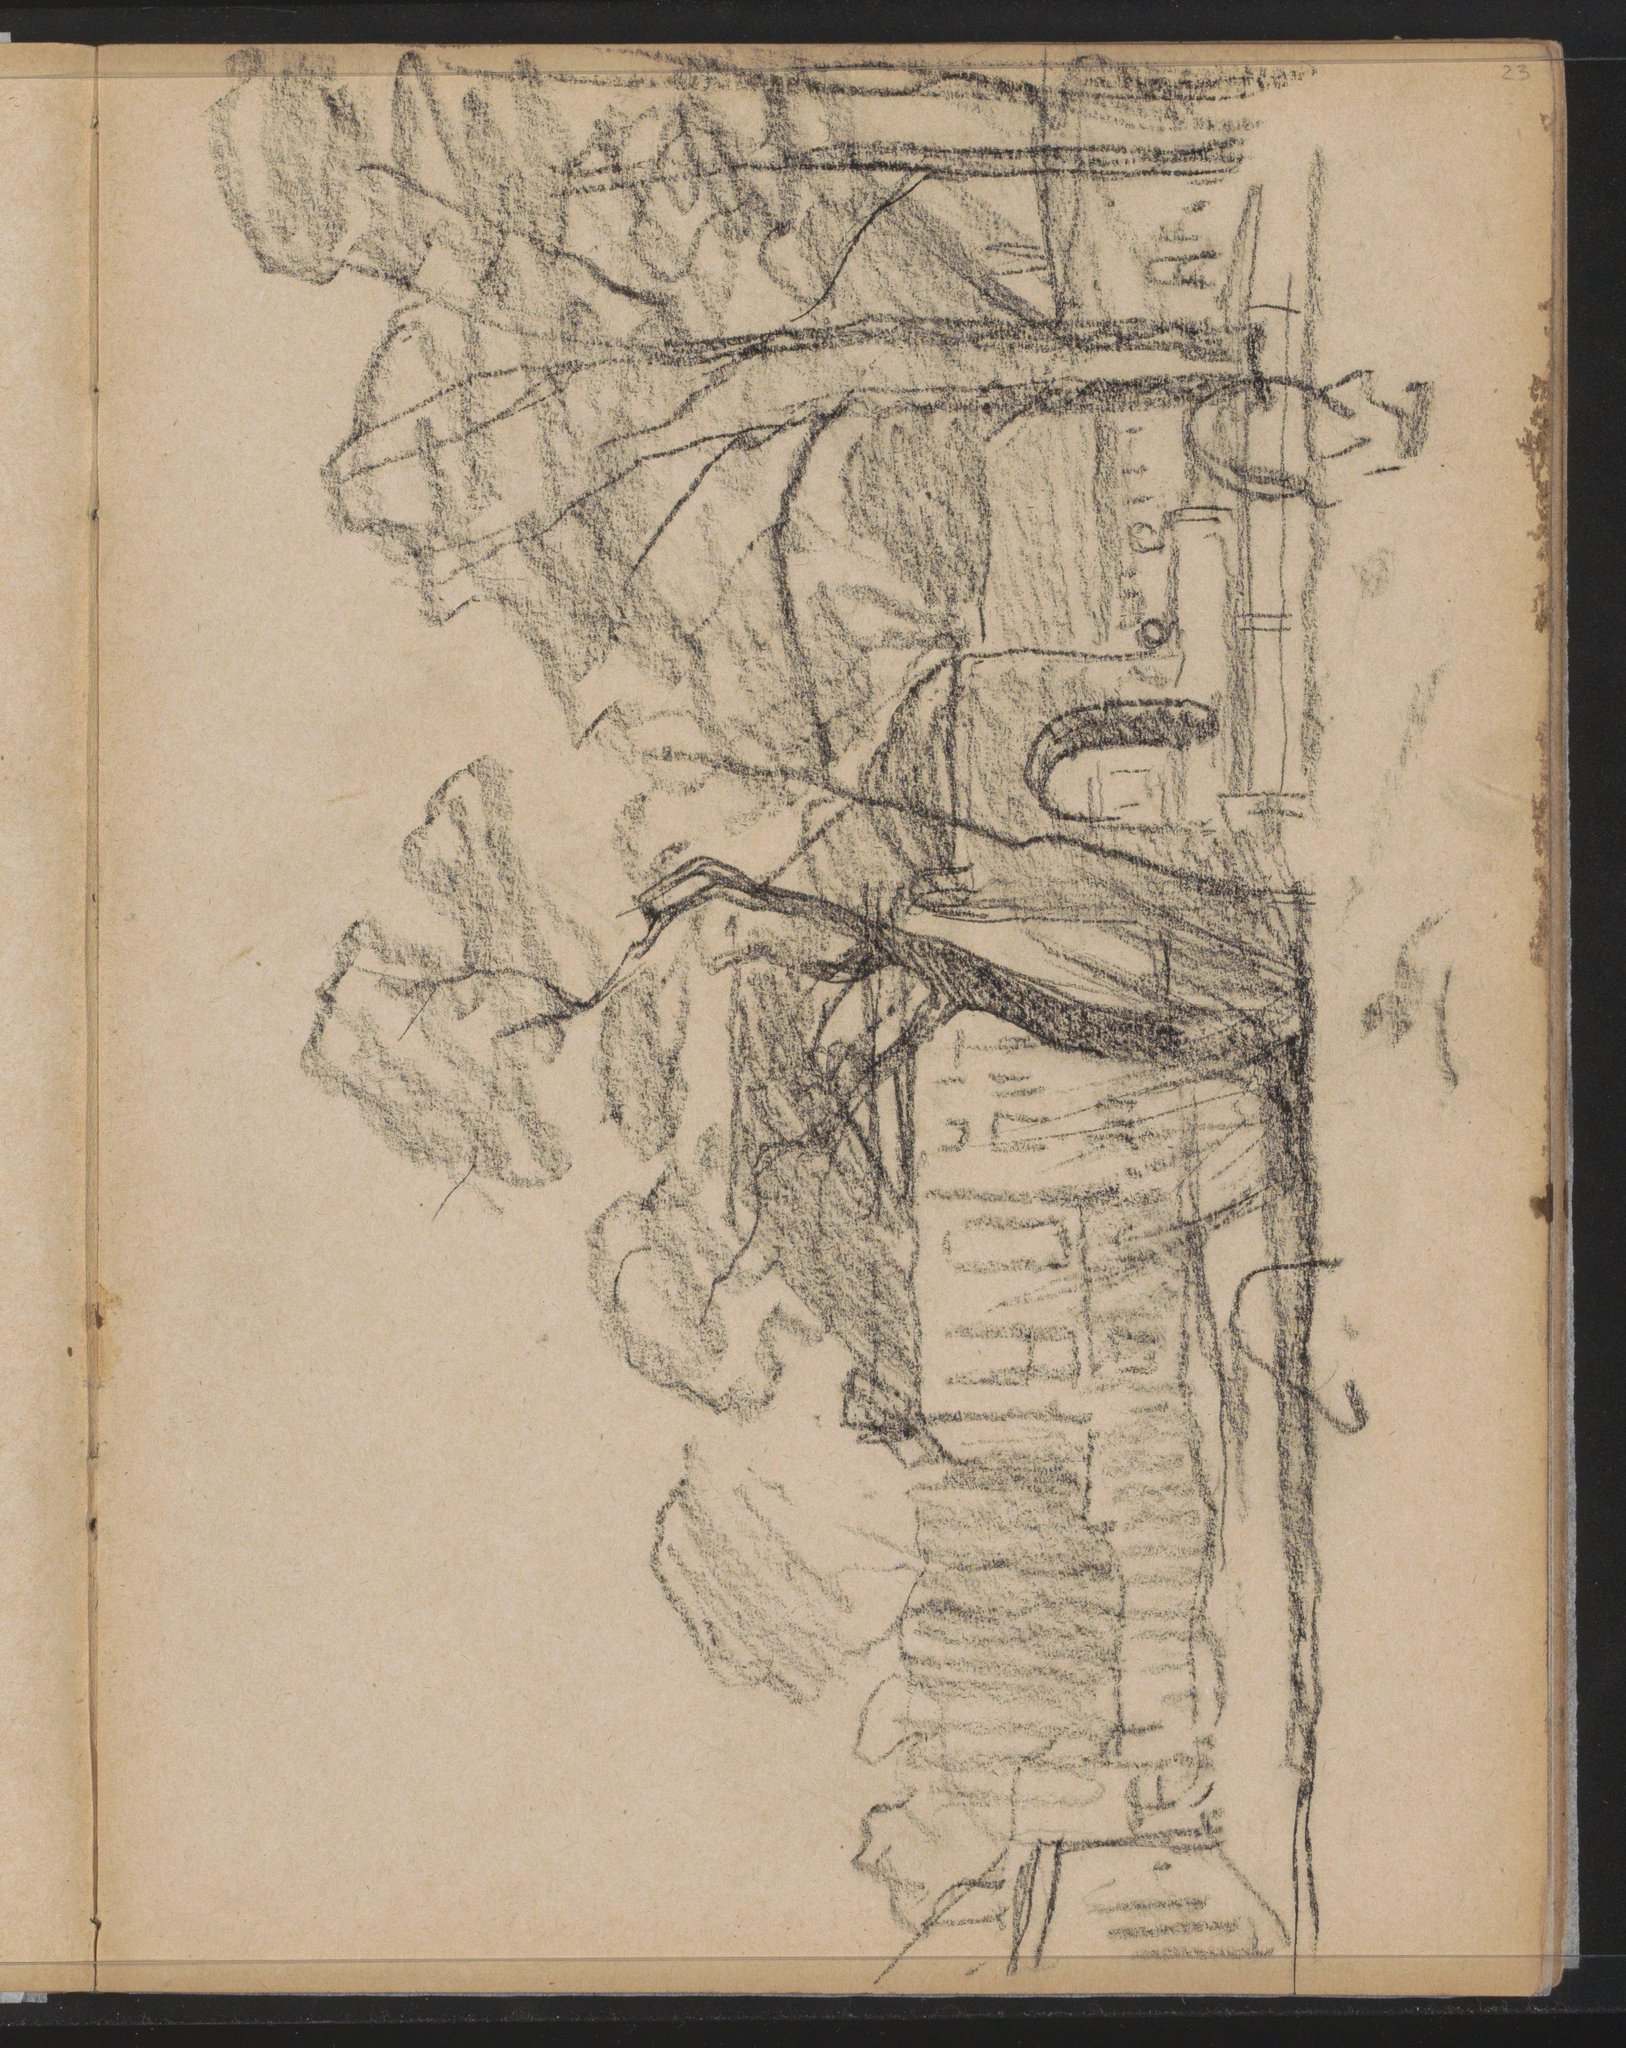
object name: sketchbook leaf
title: Gezicht op Huis Diepenheim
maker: willem witsen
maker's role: draughtsman, painter, print maker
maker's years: 1860-1923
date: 1887-1888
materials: chalk, paper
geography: diepenheim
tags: rural housing, e.g. country-house, villa, cottage, gate, entrance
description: Vooraan de toegangspoort. Pagina 23 uit een schetsboek met 43 bladen.